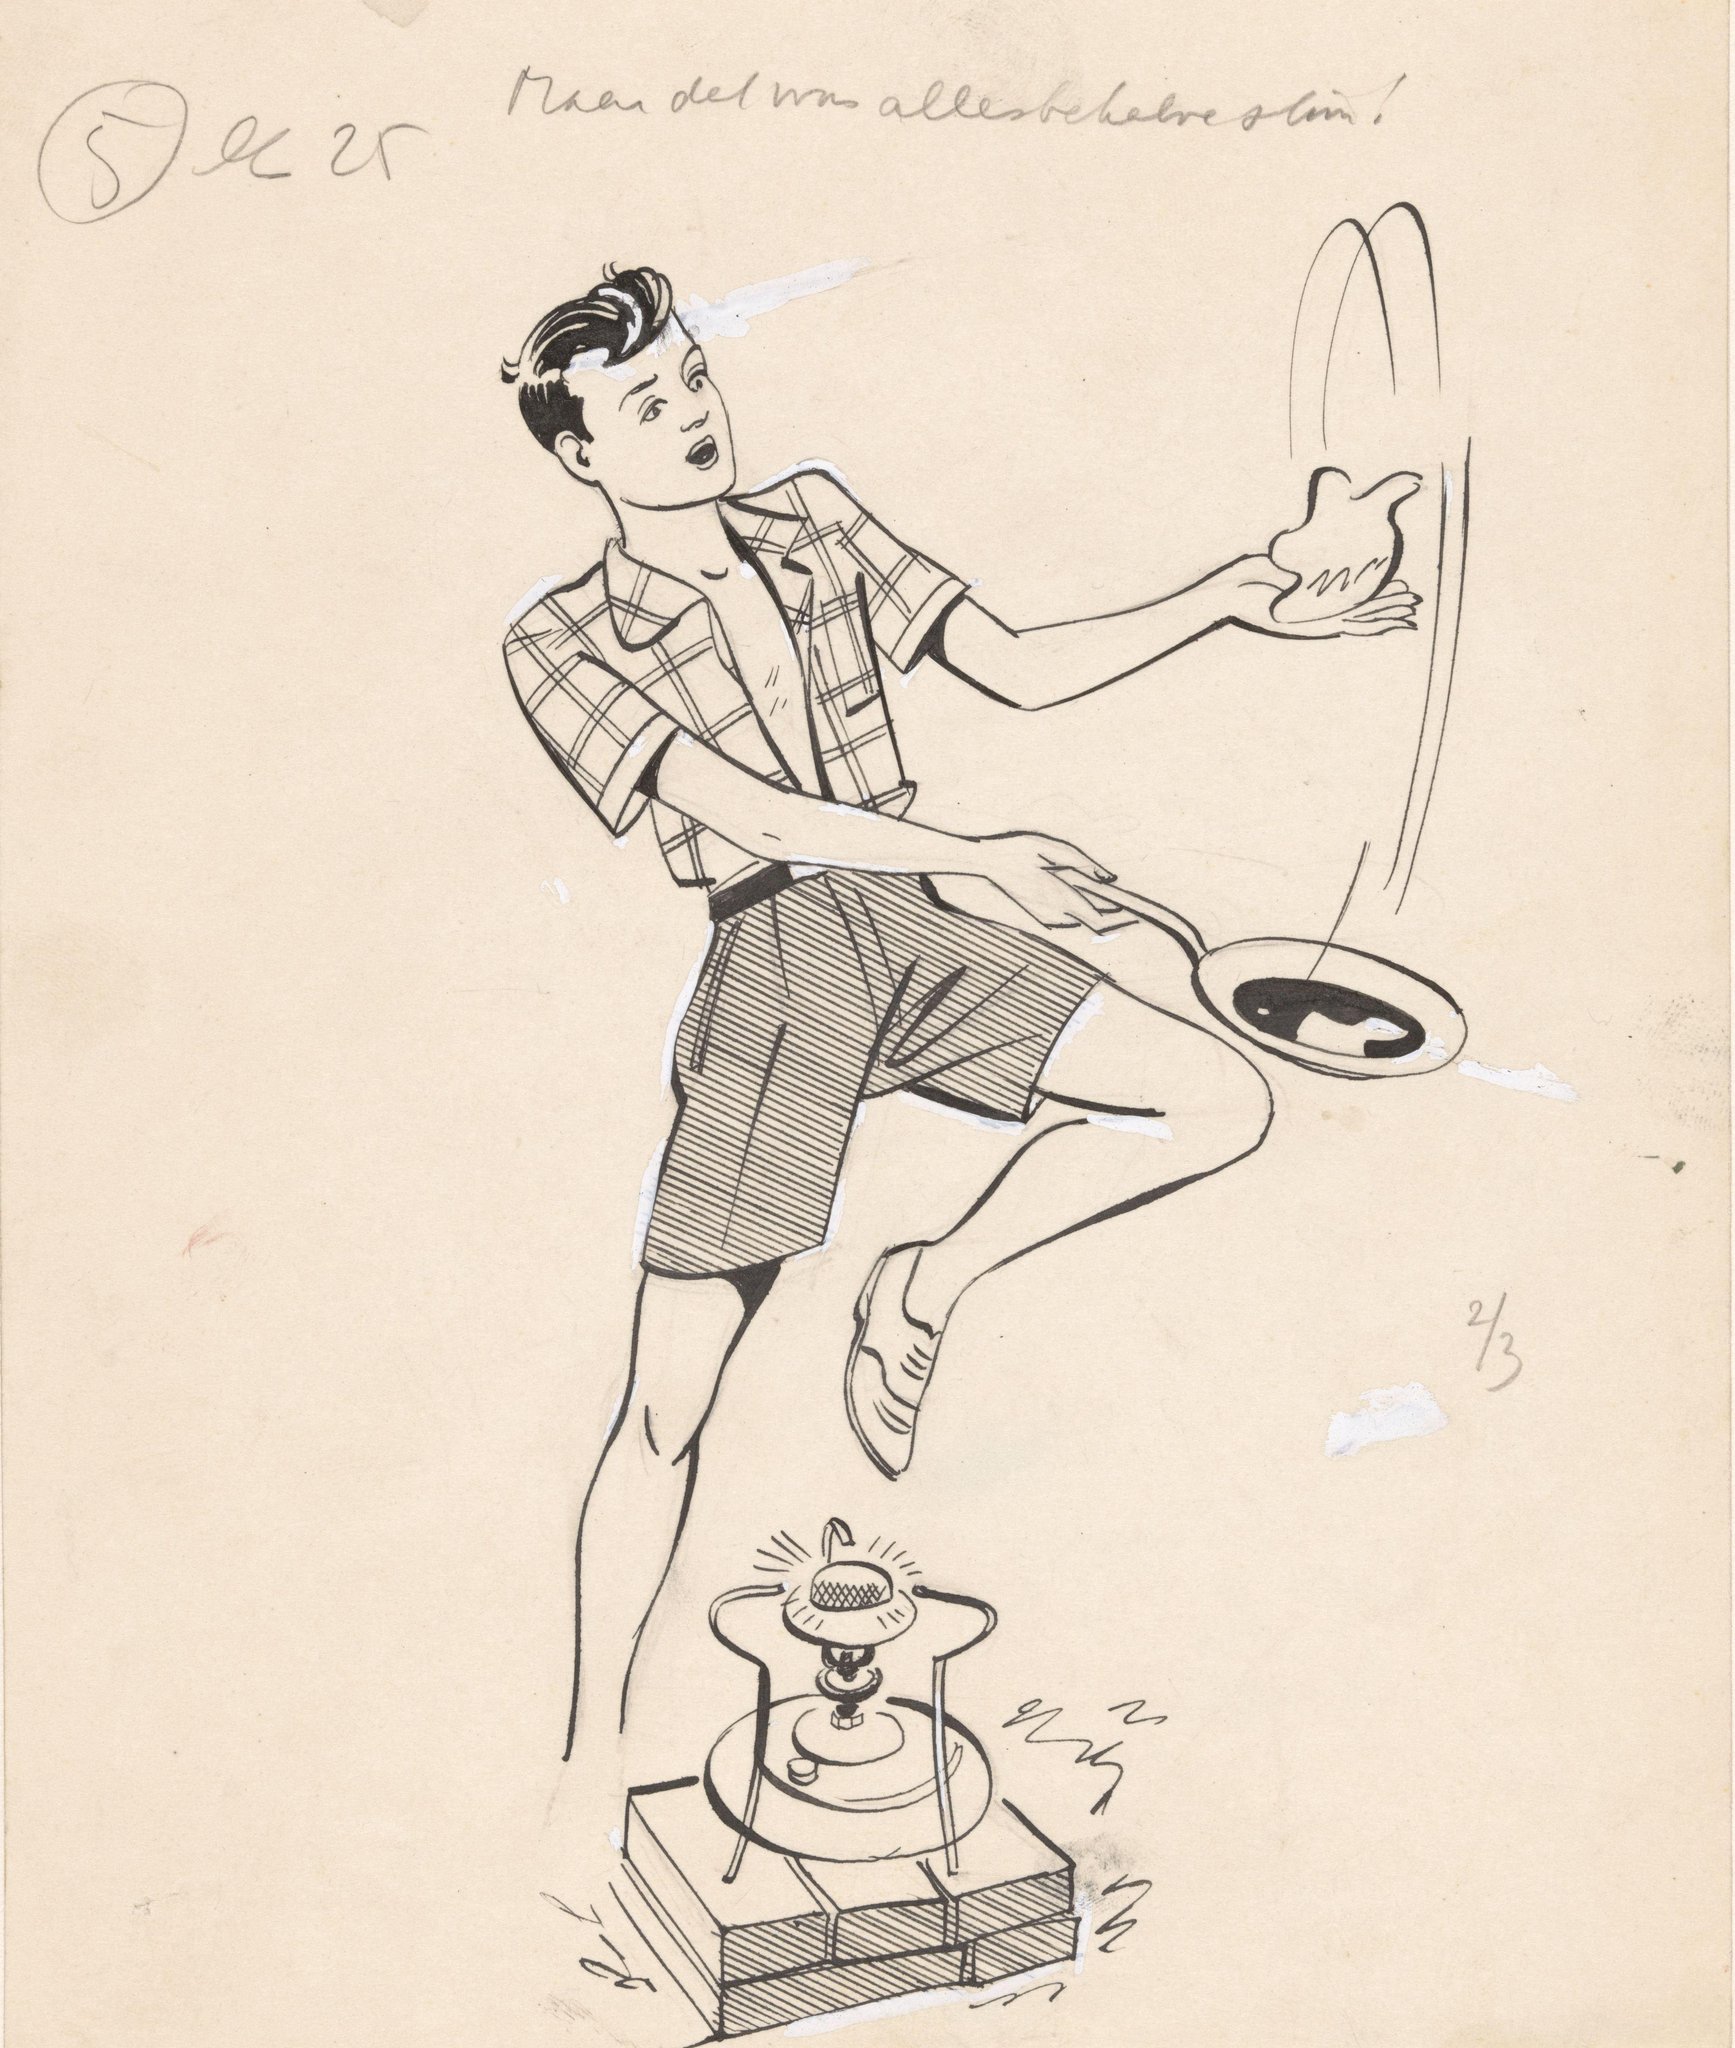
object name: drawing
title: Jongen probeert een gebakken ei om te draaien in een pan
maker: hans borrebach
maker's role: draughtsman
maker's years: 1903-1991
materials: paint, ink, paper, pencil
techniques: pen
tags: frying - cc - in the open air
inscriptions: :, collector's mark: Lugt 2228a, annotation: ‘5 blz 25/ Maar dat was alles behale slim!’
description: Een jongen gekleed in een korte broek en geruite blouse staat bij een gasbrander. Hij houdt een koekenpan in zijn rechterhand en probeert tevergeefs een gebakken ei daarin om te draaien. Het ei belandt echter in zijn linkerhand.